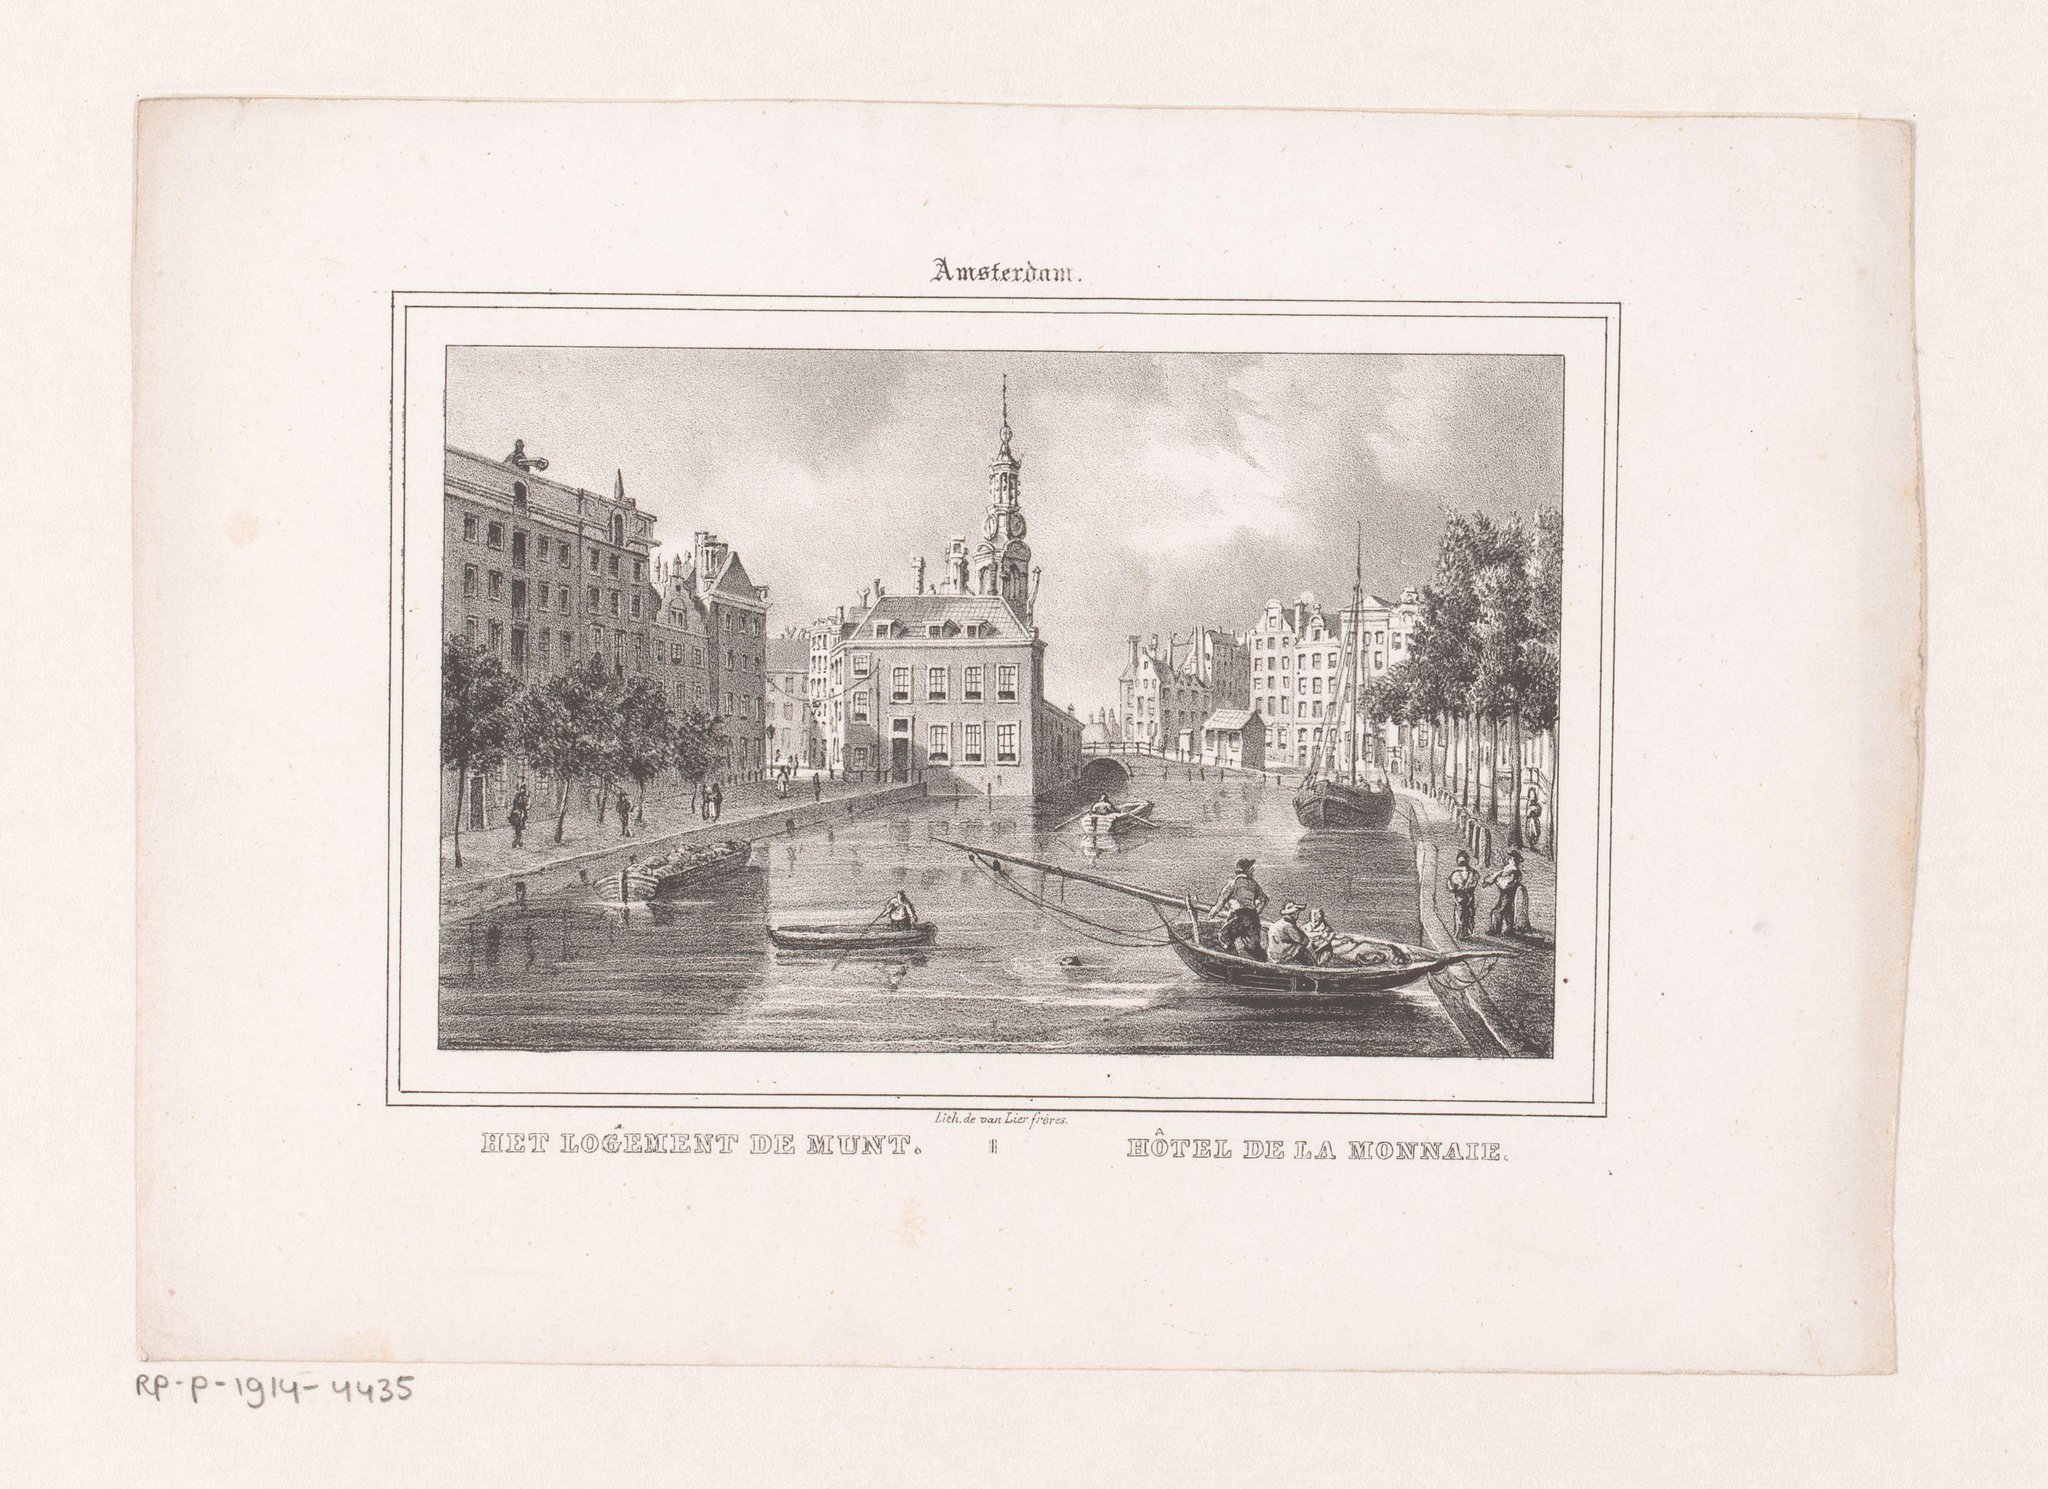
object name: print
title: Het logement De Munt te Amsterdam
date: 1833-1850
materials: paper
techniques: lithograph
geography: the hague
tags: canals, waters (in city), hotel, hostelry, inn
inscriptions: collector's mark: Lugt 2228